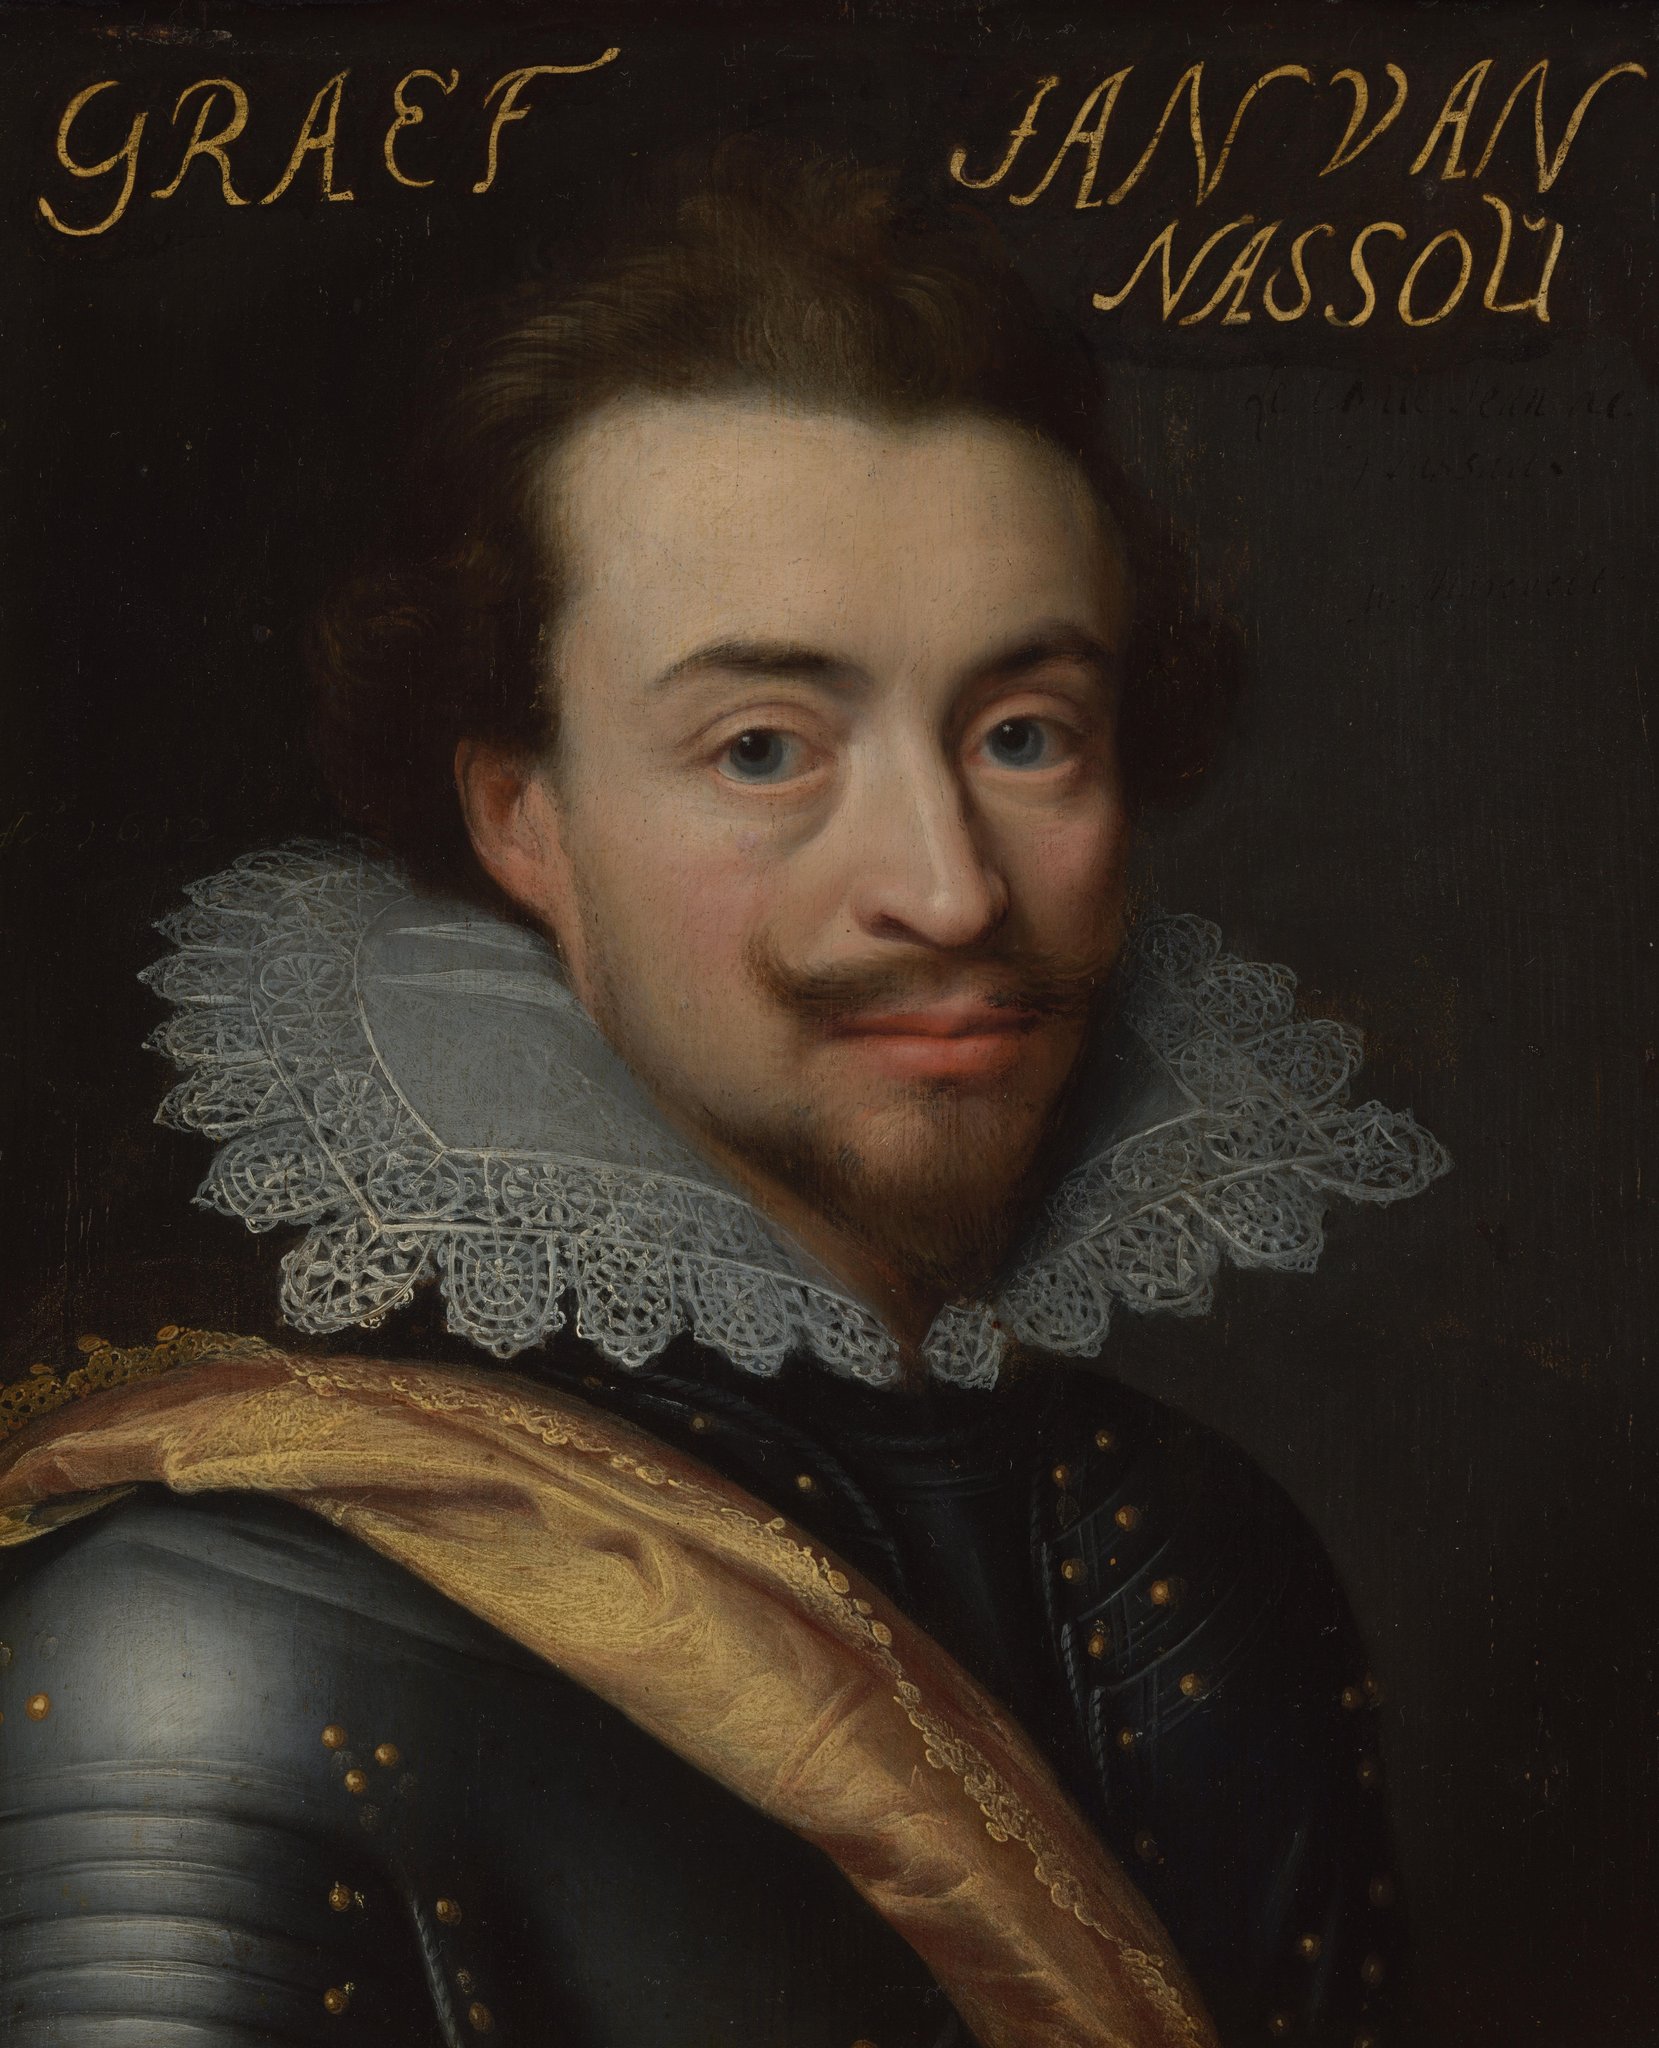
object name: painting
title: Portrait of Jan the Younger (1583-1638), Count of Nassau-Siegen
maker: jan antonisz van ravesteyn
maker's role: draughtsman, painter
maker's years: 1570-1657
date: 1614-1633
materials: oil, panel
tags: historical persons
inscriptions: inscription, top: ‘GRAEF JAN VAN NASSOU’, inscription, upper right: ‘Le comte Jean de Nassau / M. Mirevelt’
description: Portret van Jan de Jongere (1583-1638), graaf van Nassau-Siegen. Buste naar rechts, in wapenrusting. Onderdeel van de reeks portretten afkomstig uit het Stadhouderlijk Hof te Leeuwarden.